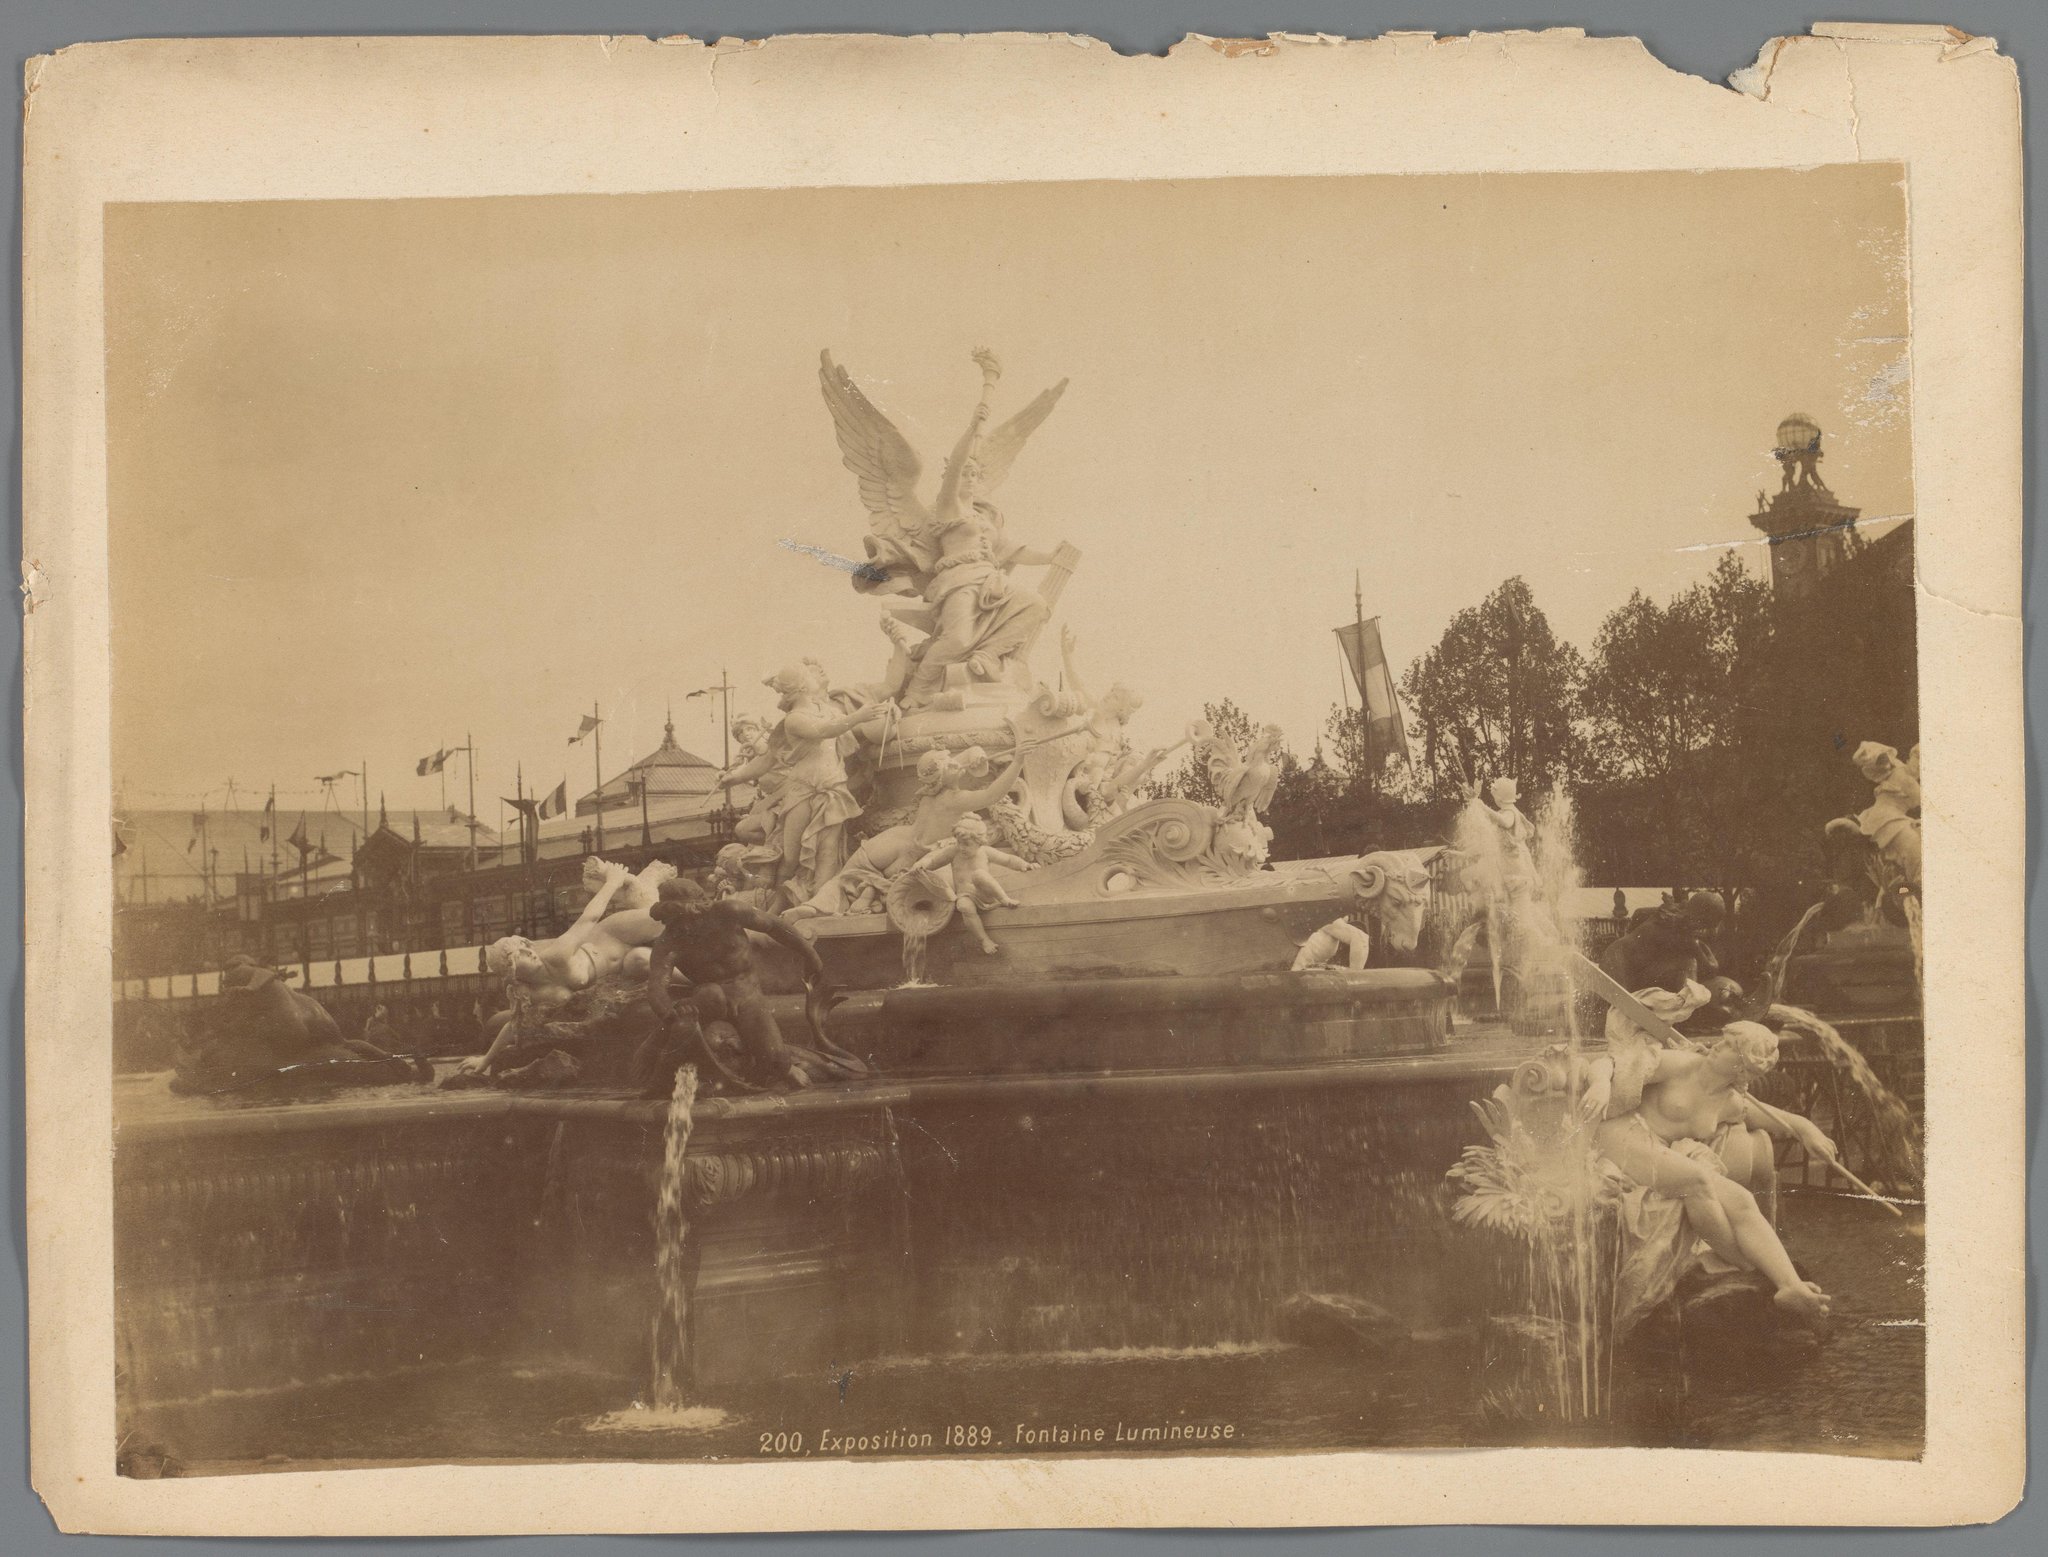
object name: photograph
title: Fontaine Lumineuse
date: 1889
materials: cardboard, paper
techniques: albumen print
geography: paris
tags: ornamental fountain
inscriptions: number: ‘200,’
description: Tussen 1887 en ca. 1900 werkten Neurdein frères onder andere onder de naam 'X phot.'.